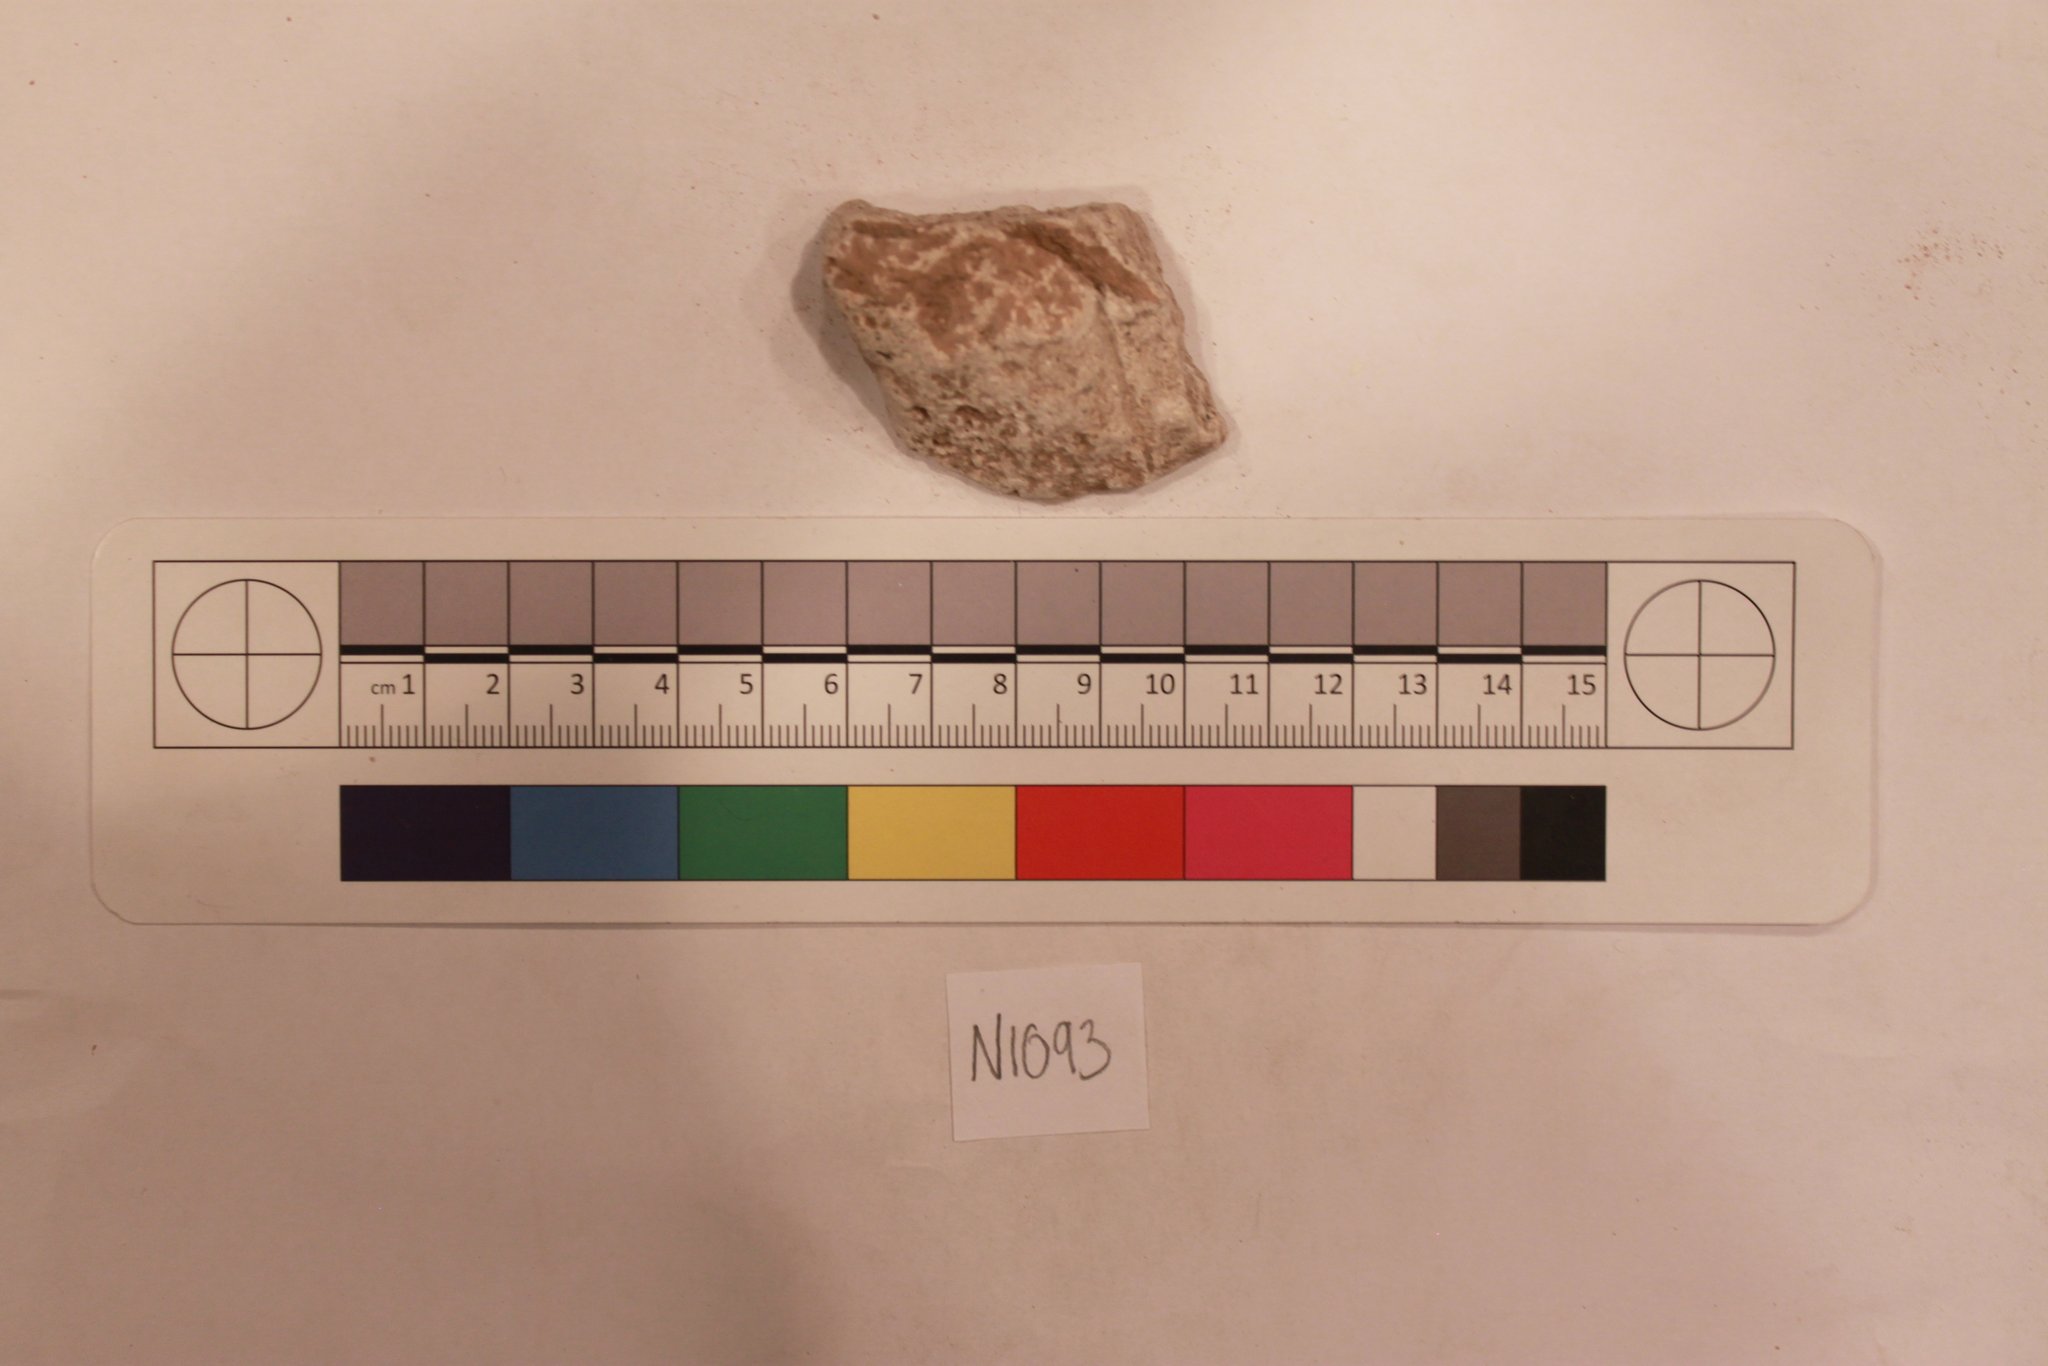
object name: fragment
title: Stucco Fragment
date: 701-1200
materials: plaster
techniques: carving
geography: iran